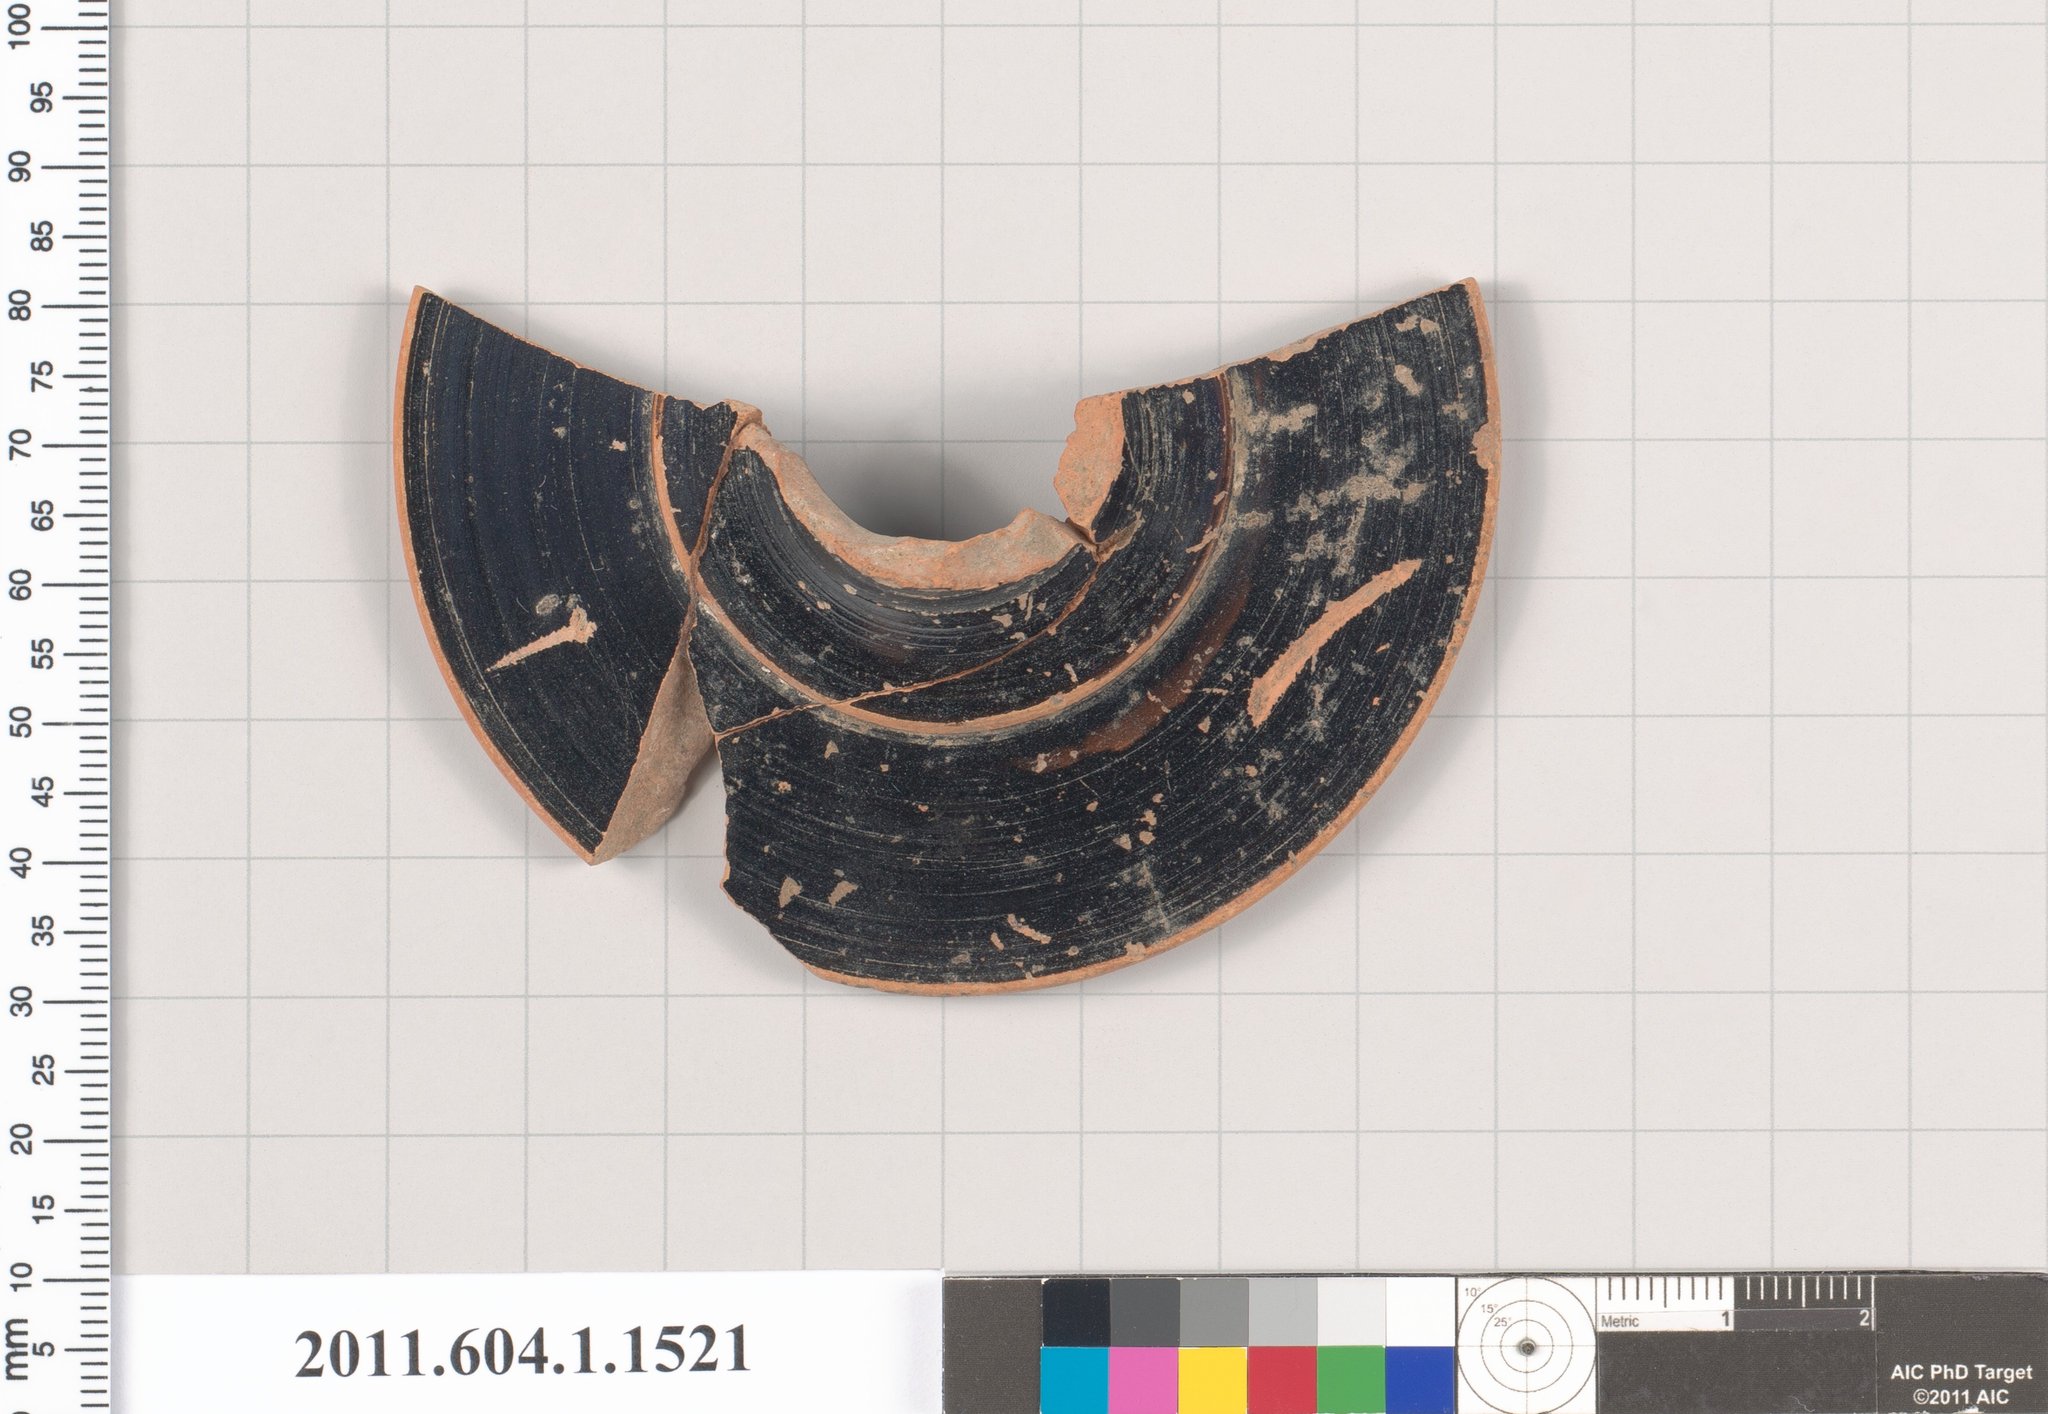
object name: kylix fragment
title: Terracotta fragment of a kylix (drinking cup)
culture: greek, attic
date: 500-401 BCE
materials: terracotta